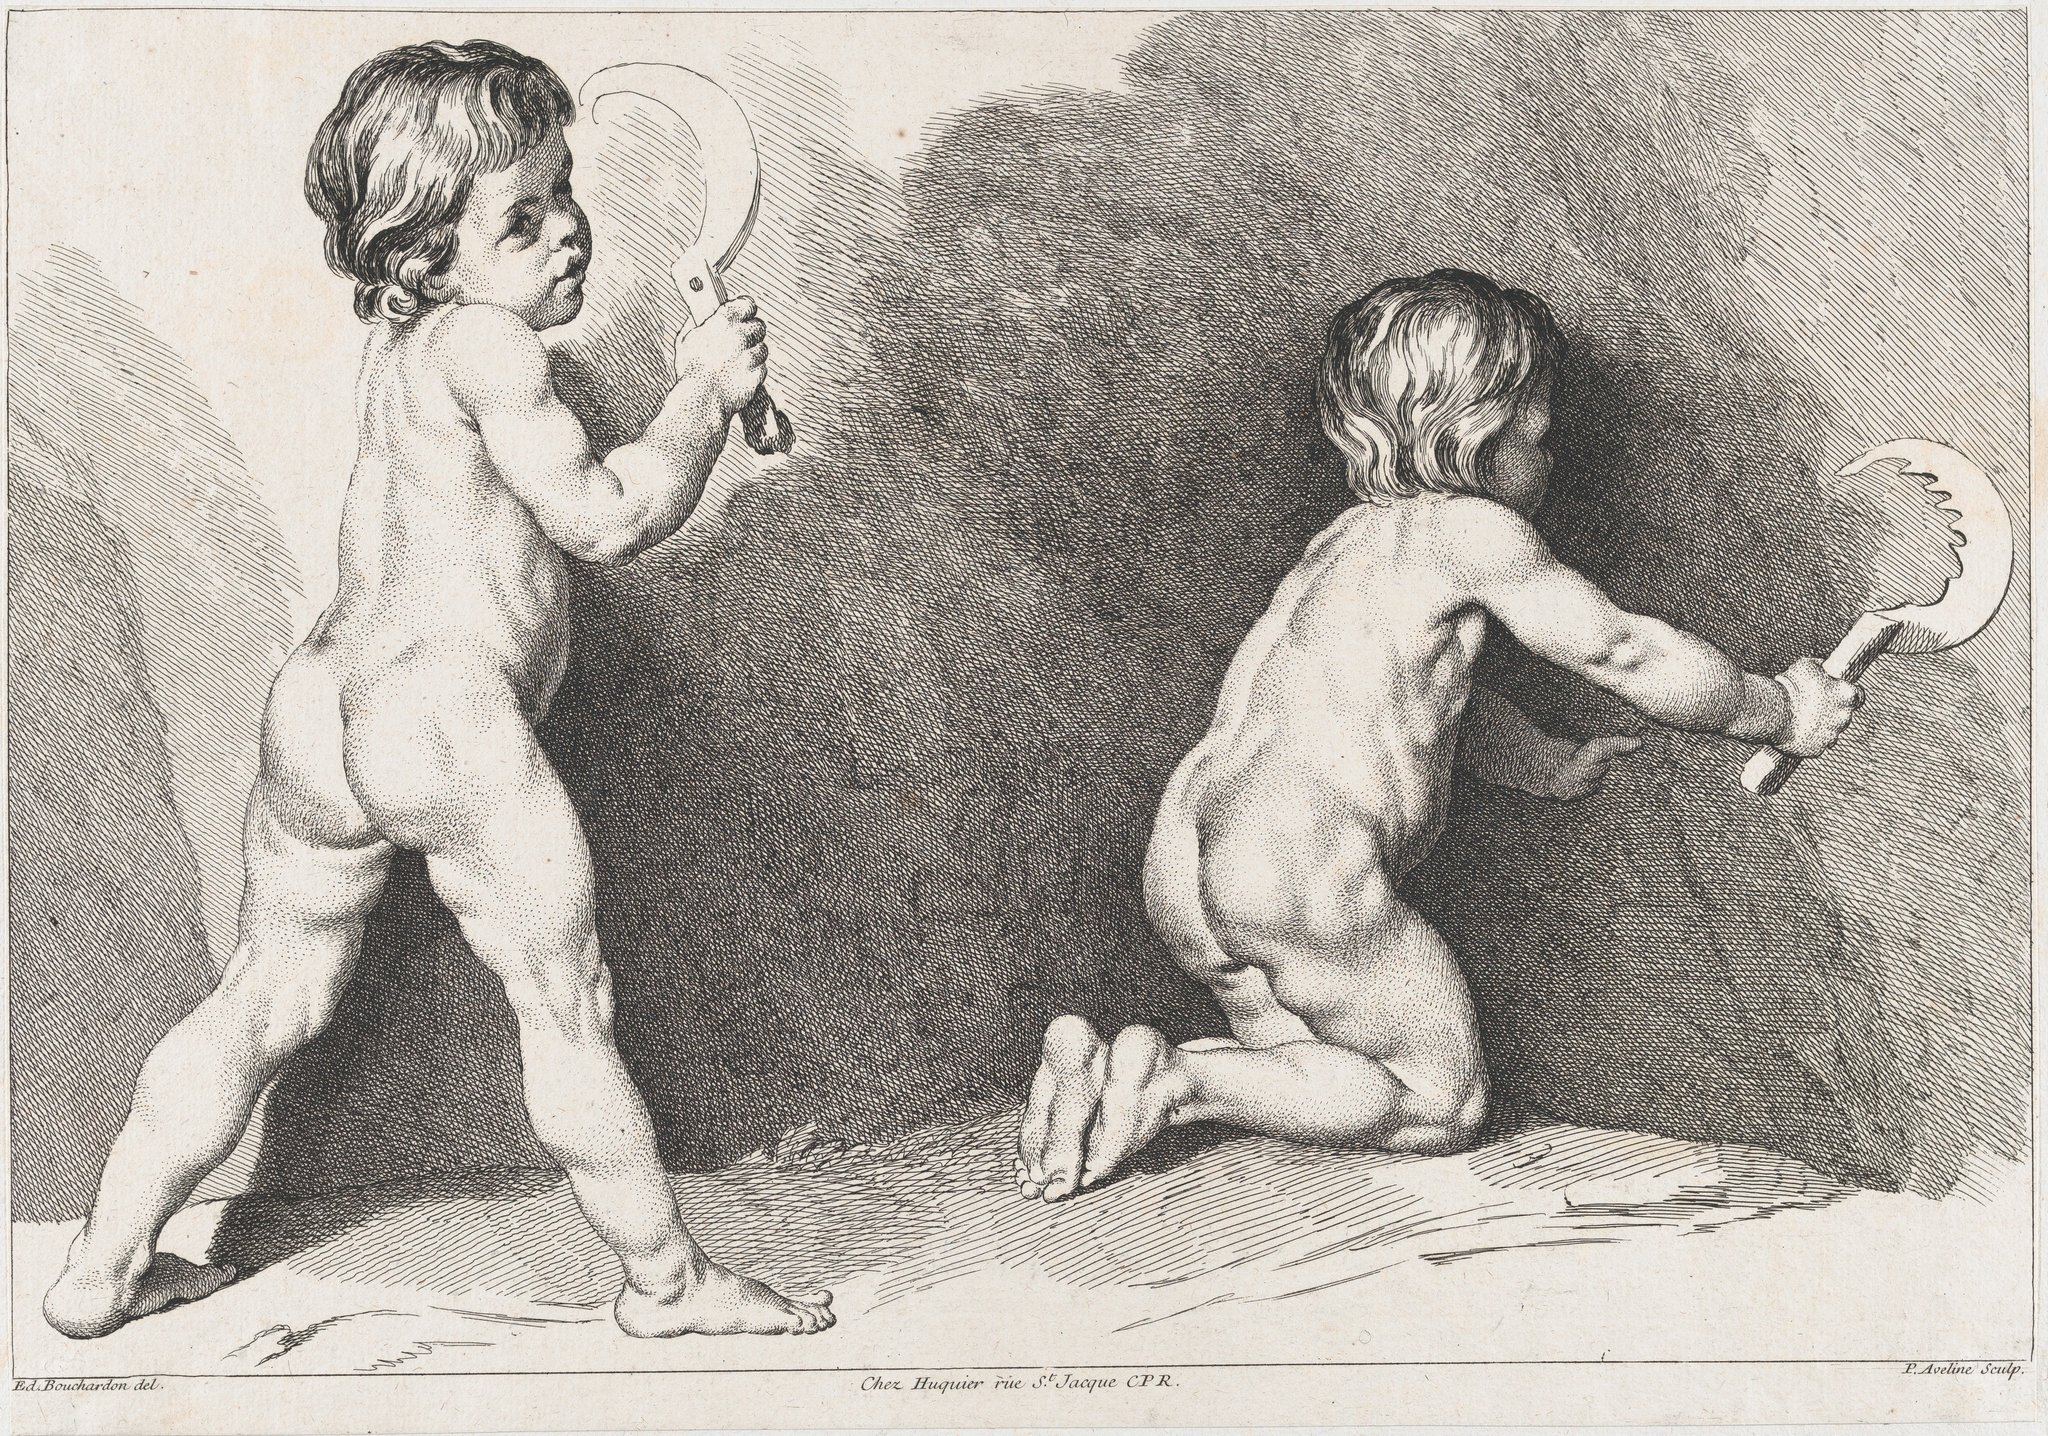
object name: print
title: Two nude children standing, from "New Book of Children"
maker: pierre alexandre aveline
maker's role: artist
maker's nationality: french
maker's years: 1702-1760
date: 1720-1760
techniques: etching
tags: children